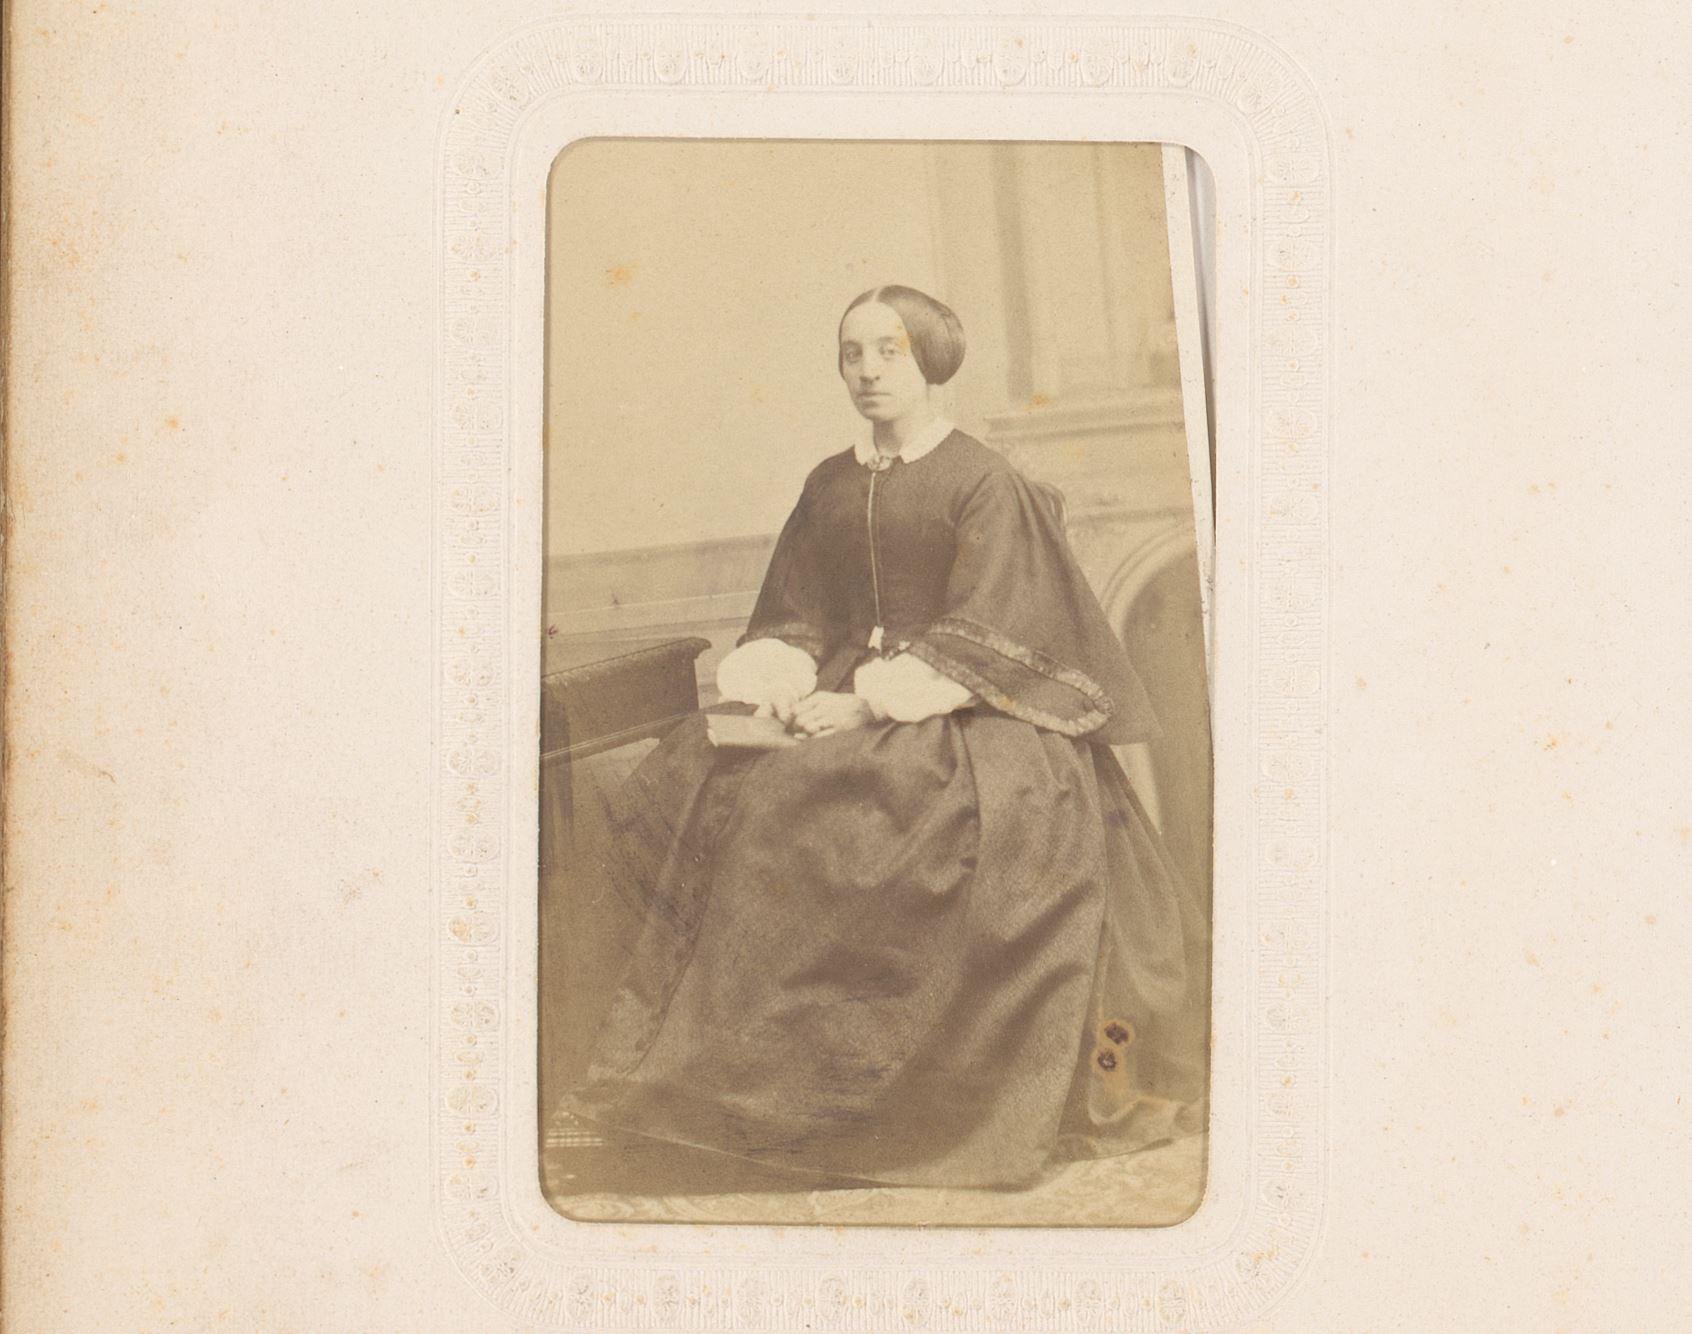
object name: photograph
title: Portret van een zittende vrouw met boek in de hand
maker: Anonymous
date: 1860-1900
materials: cardboard, photographic support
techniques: albumen print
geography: netherlands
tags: sitting figure - aa - female human figure, historical persons - bb - woman, book